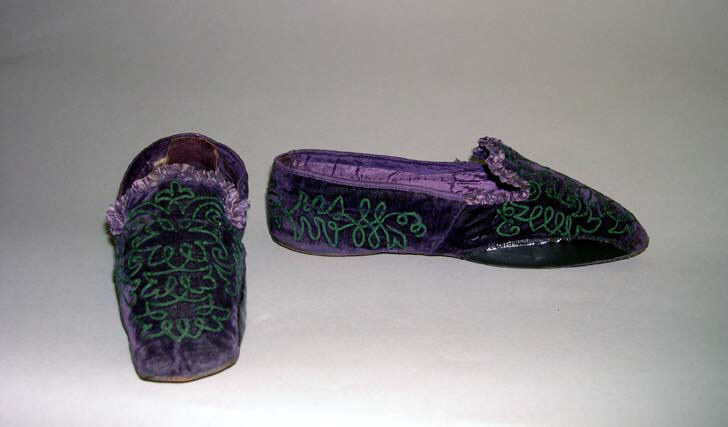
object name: shoe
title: Shoes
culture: american or european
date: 1840-1849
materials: silk